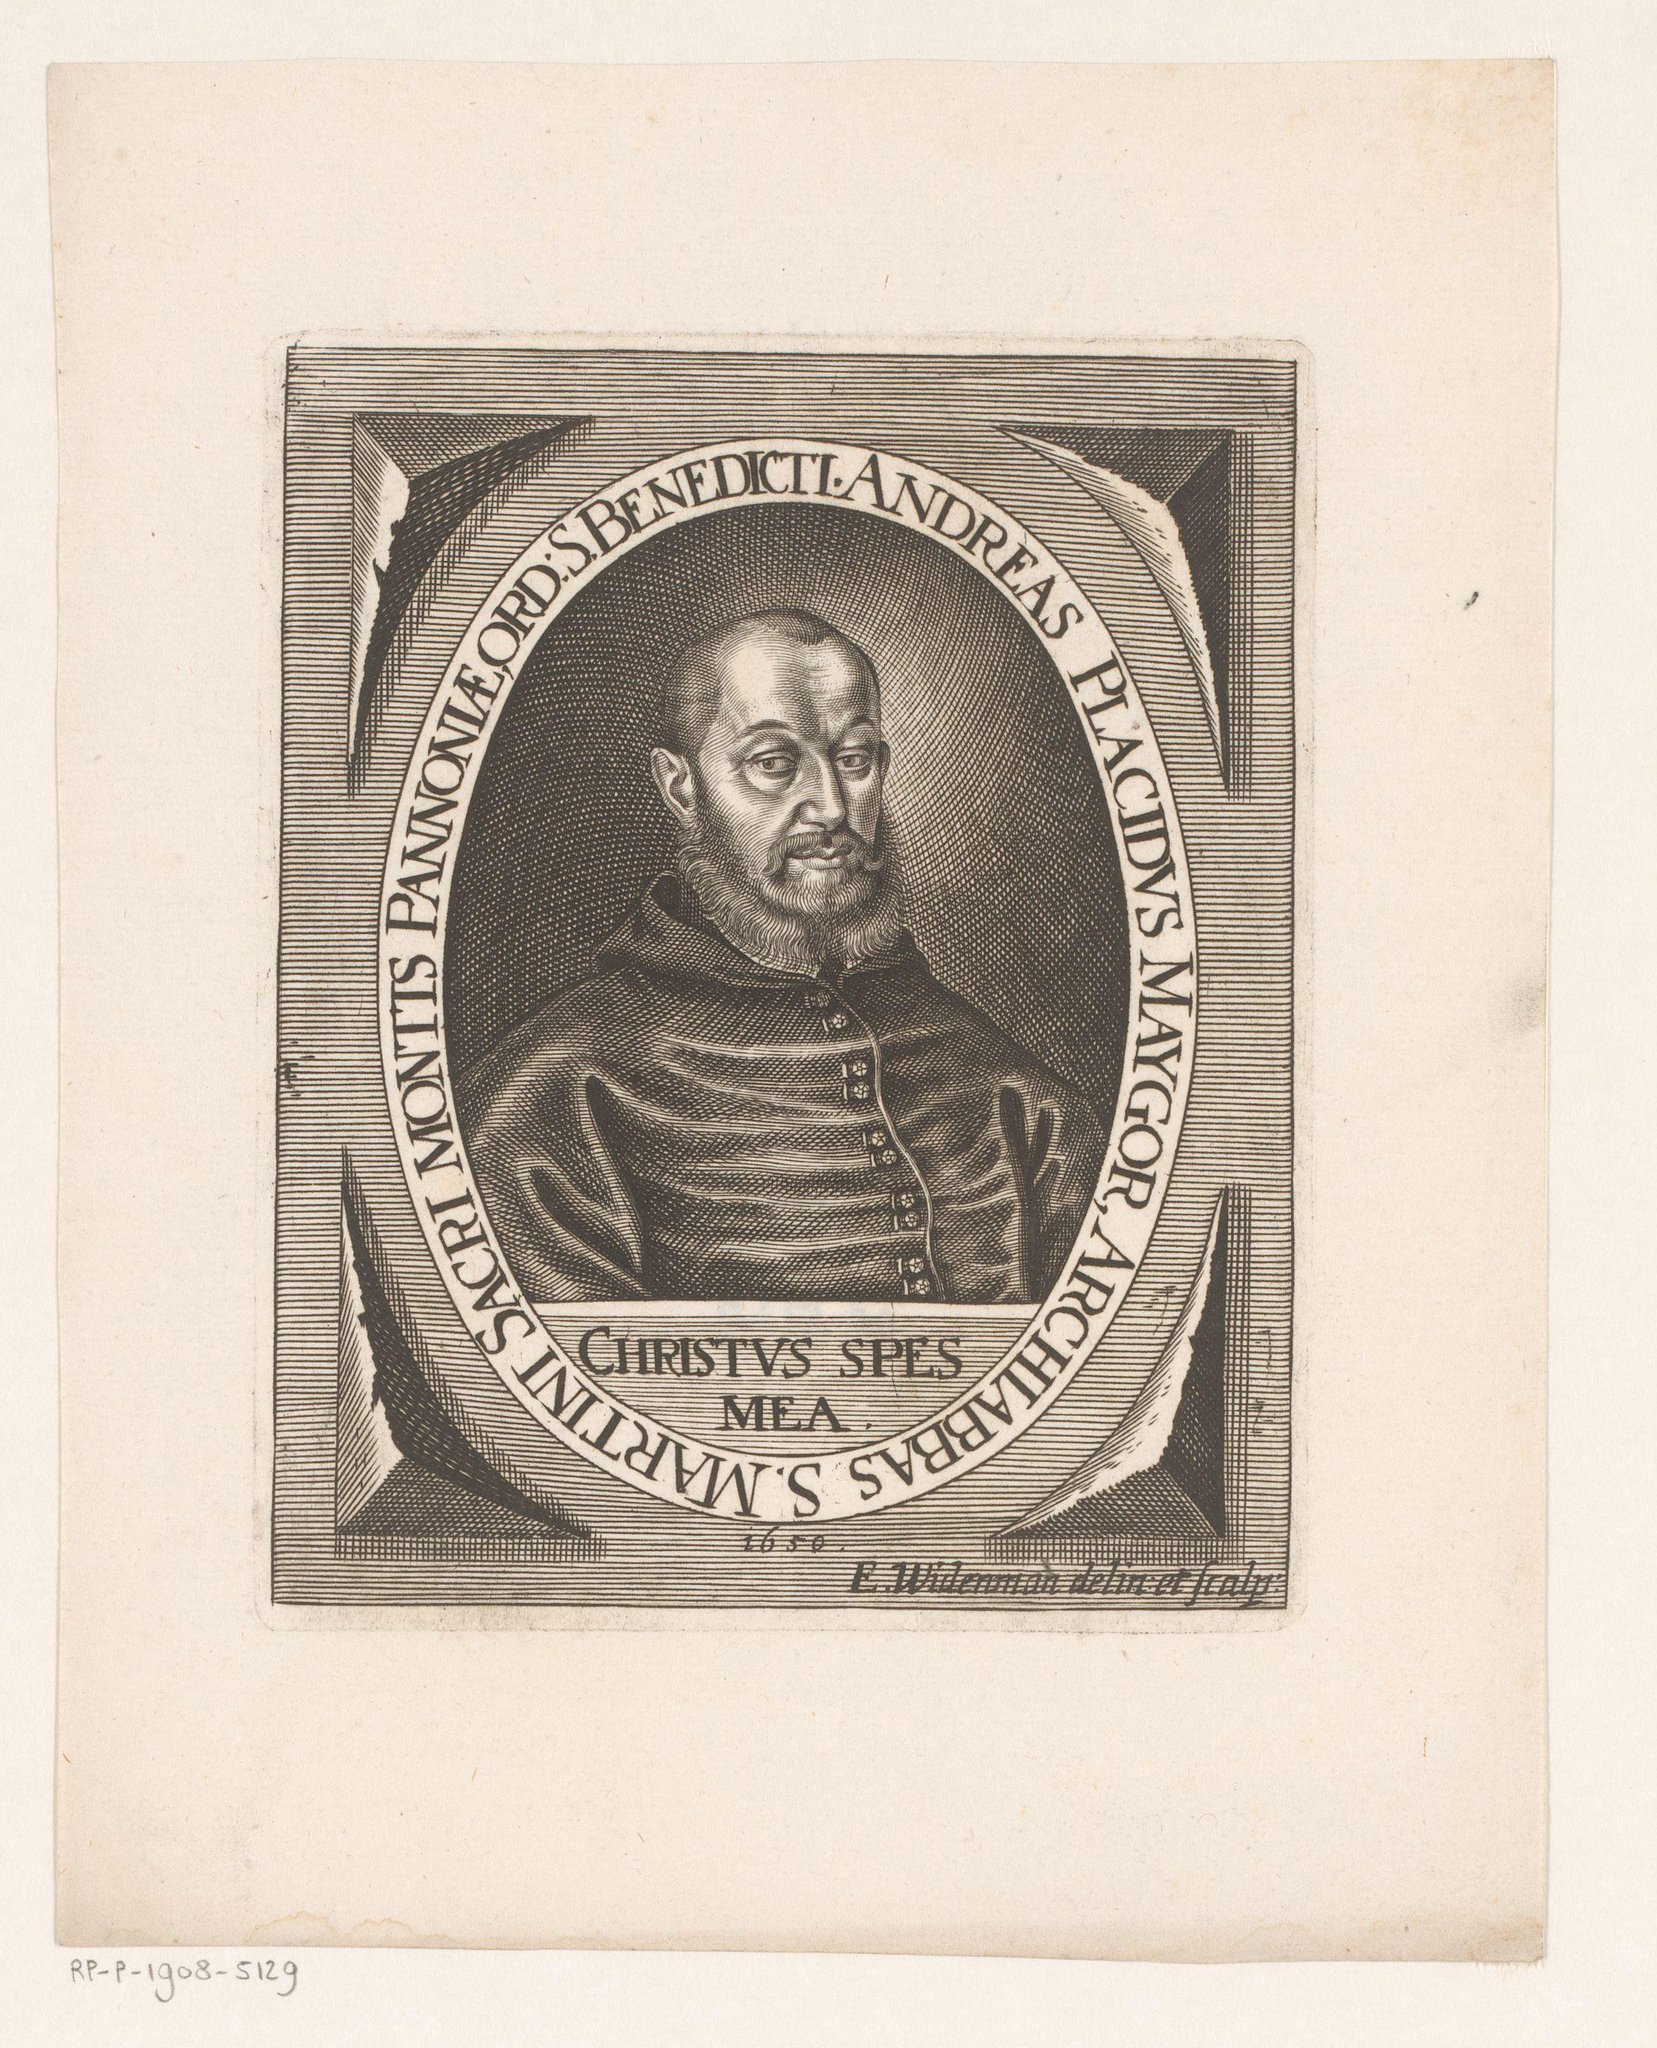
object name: print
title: Portret van András Placid Magger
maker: elias widemann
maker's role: print maker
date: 1650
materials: paper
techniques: engraving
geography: vienna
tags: historical persons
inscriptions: collector's mark: Lugt 2228